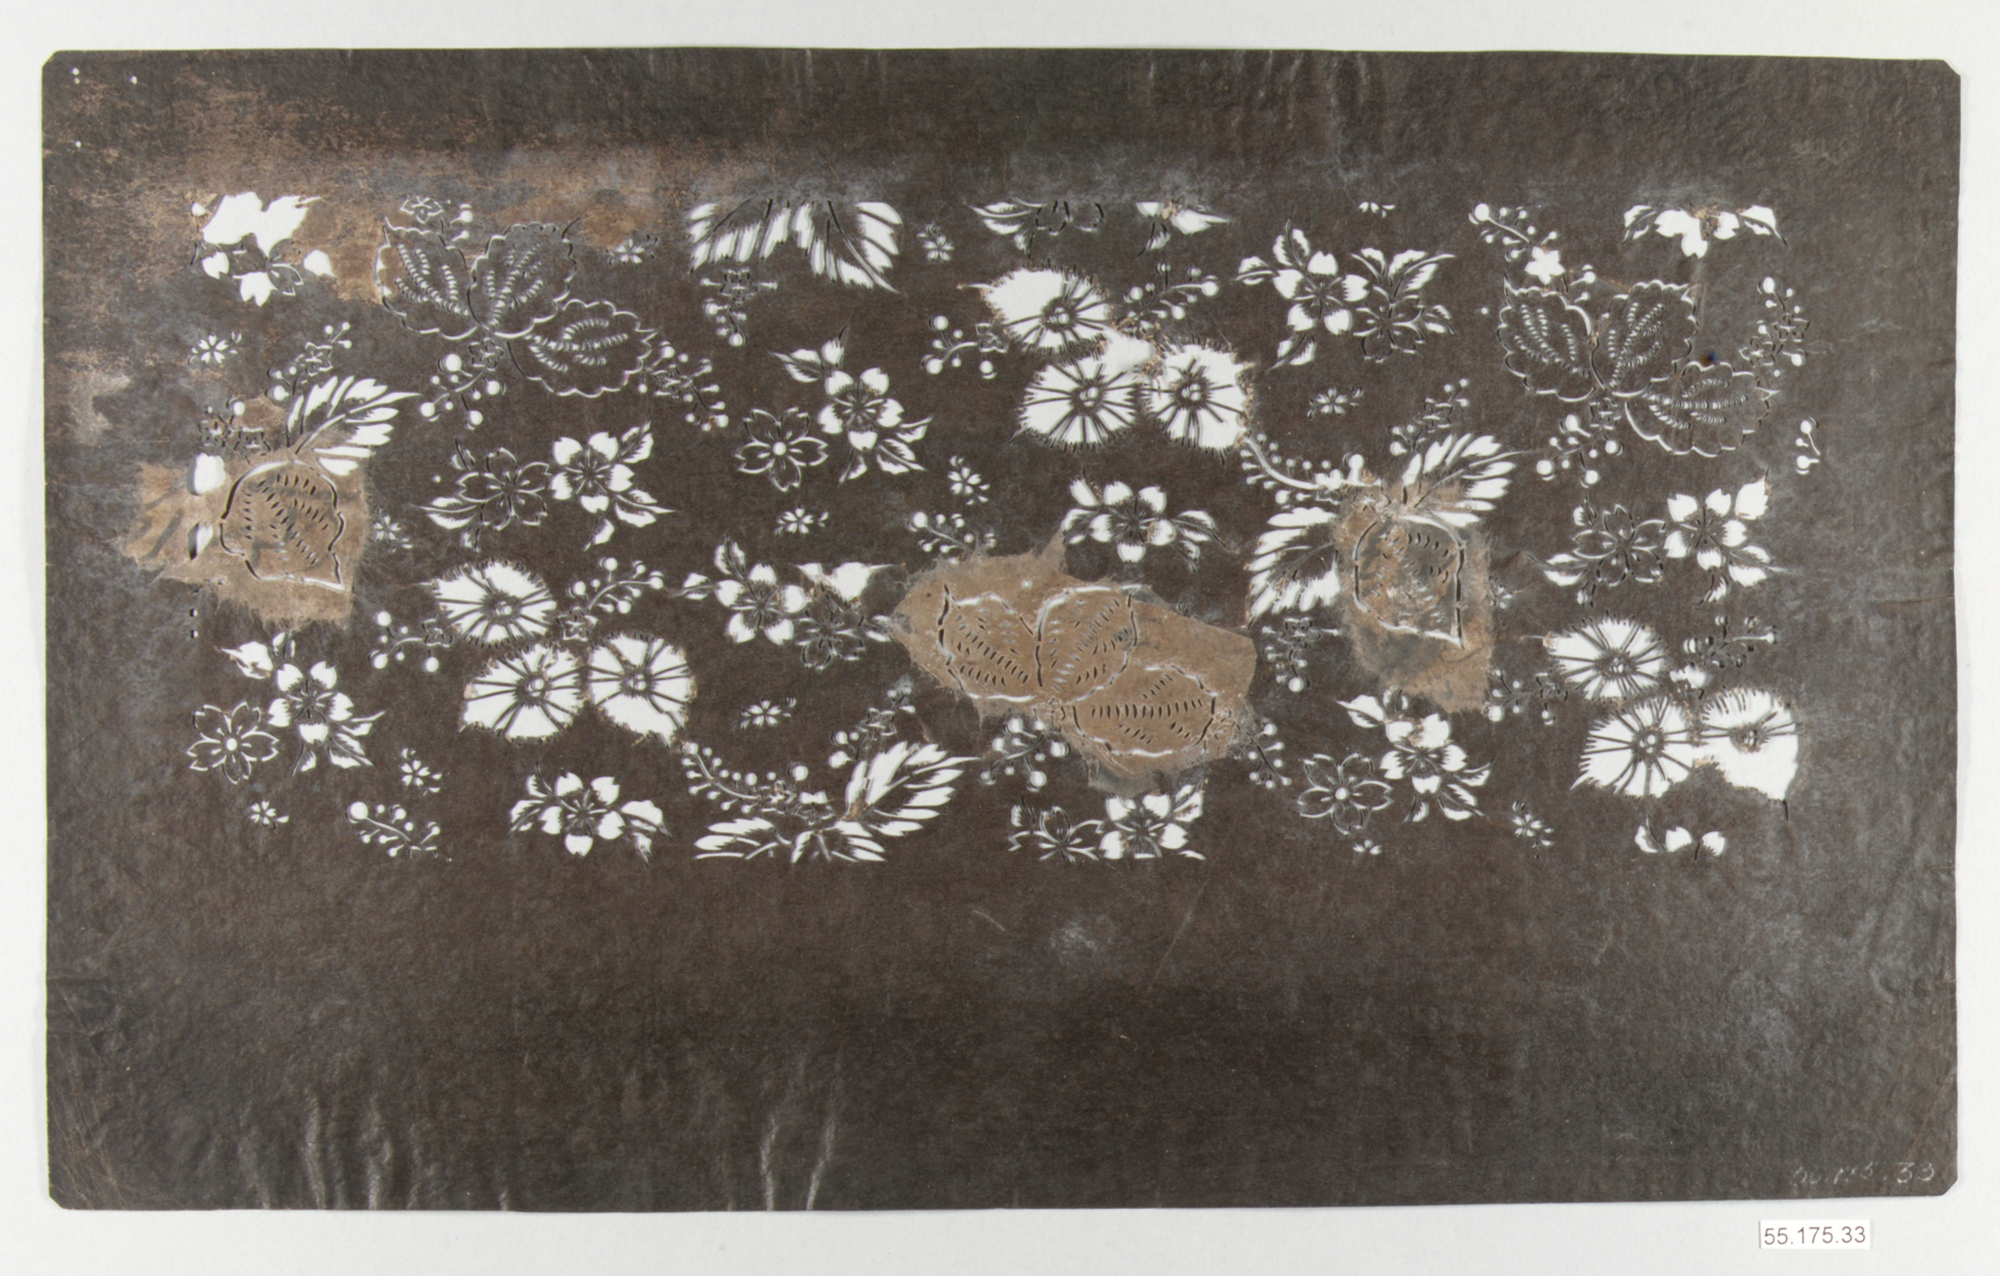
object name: stencil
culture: japanese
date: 1801-1900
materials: paper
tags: flowers